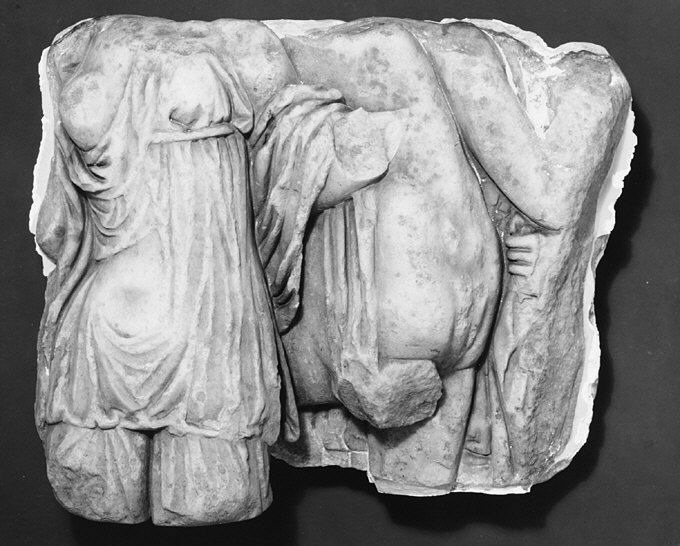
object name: sarcophagus fragment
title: Marble sarcophagus fragment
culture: roman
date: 101-200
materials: marble